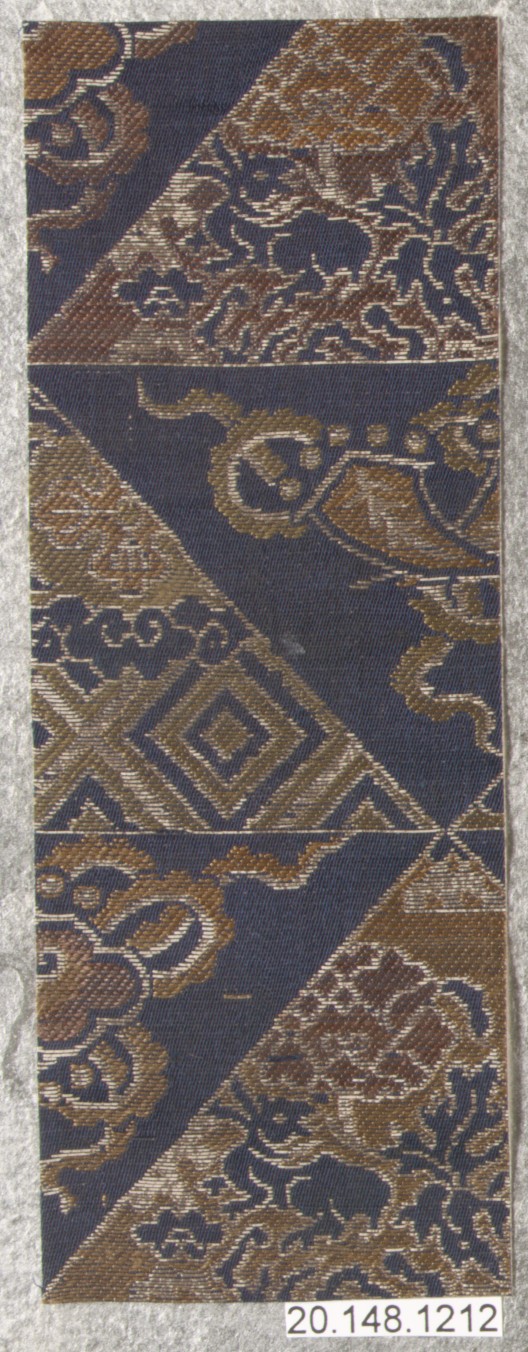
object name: piece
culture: japanese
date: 1801-1900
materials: silk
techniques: compound weave